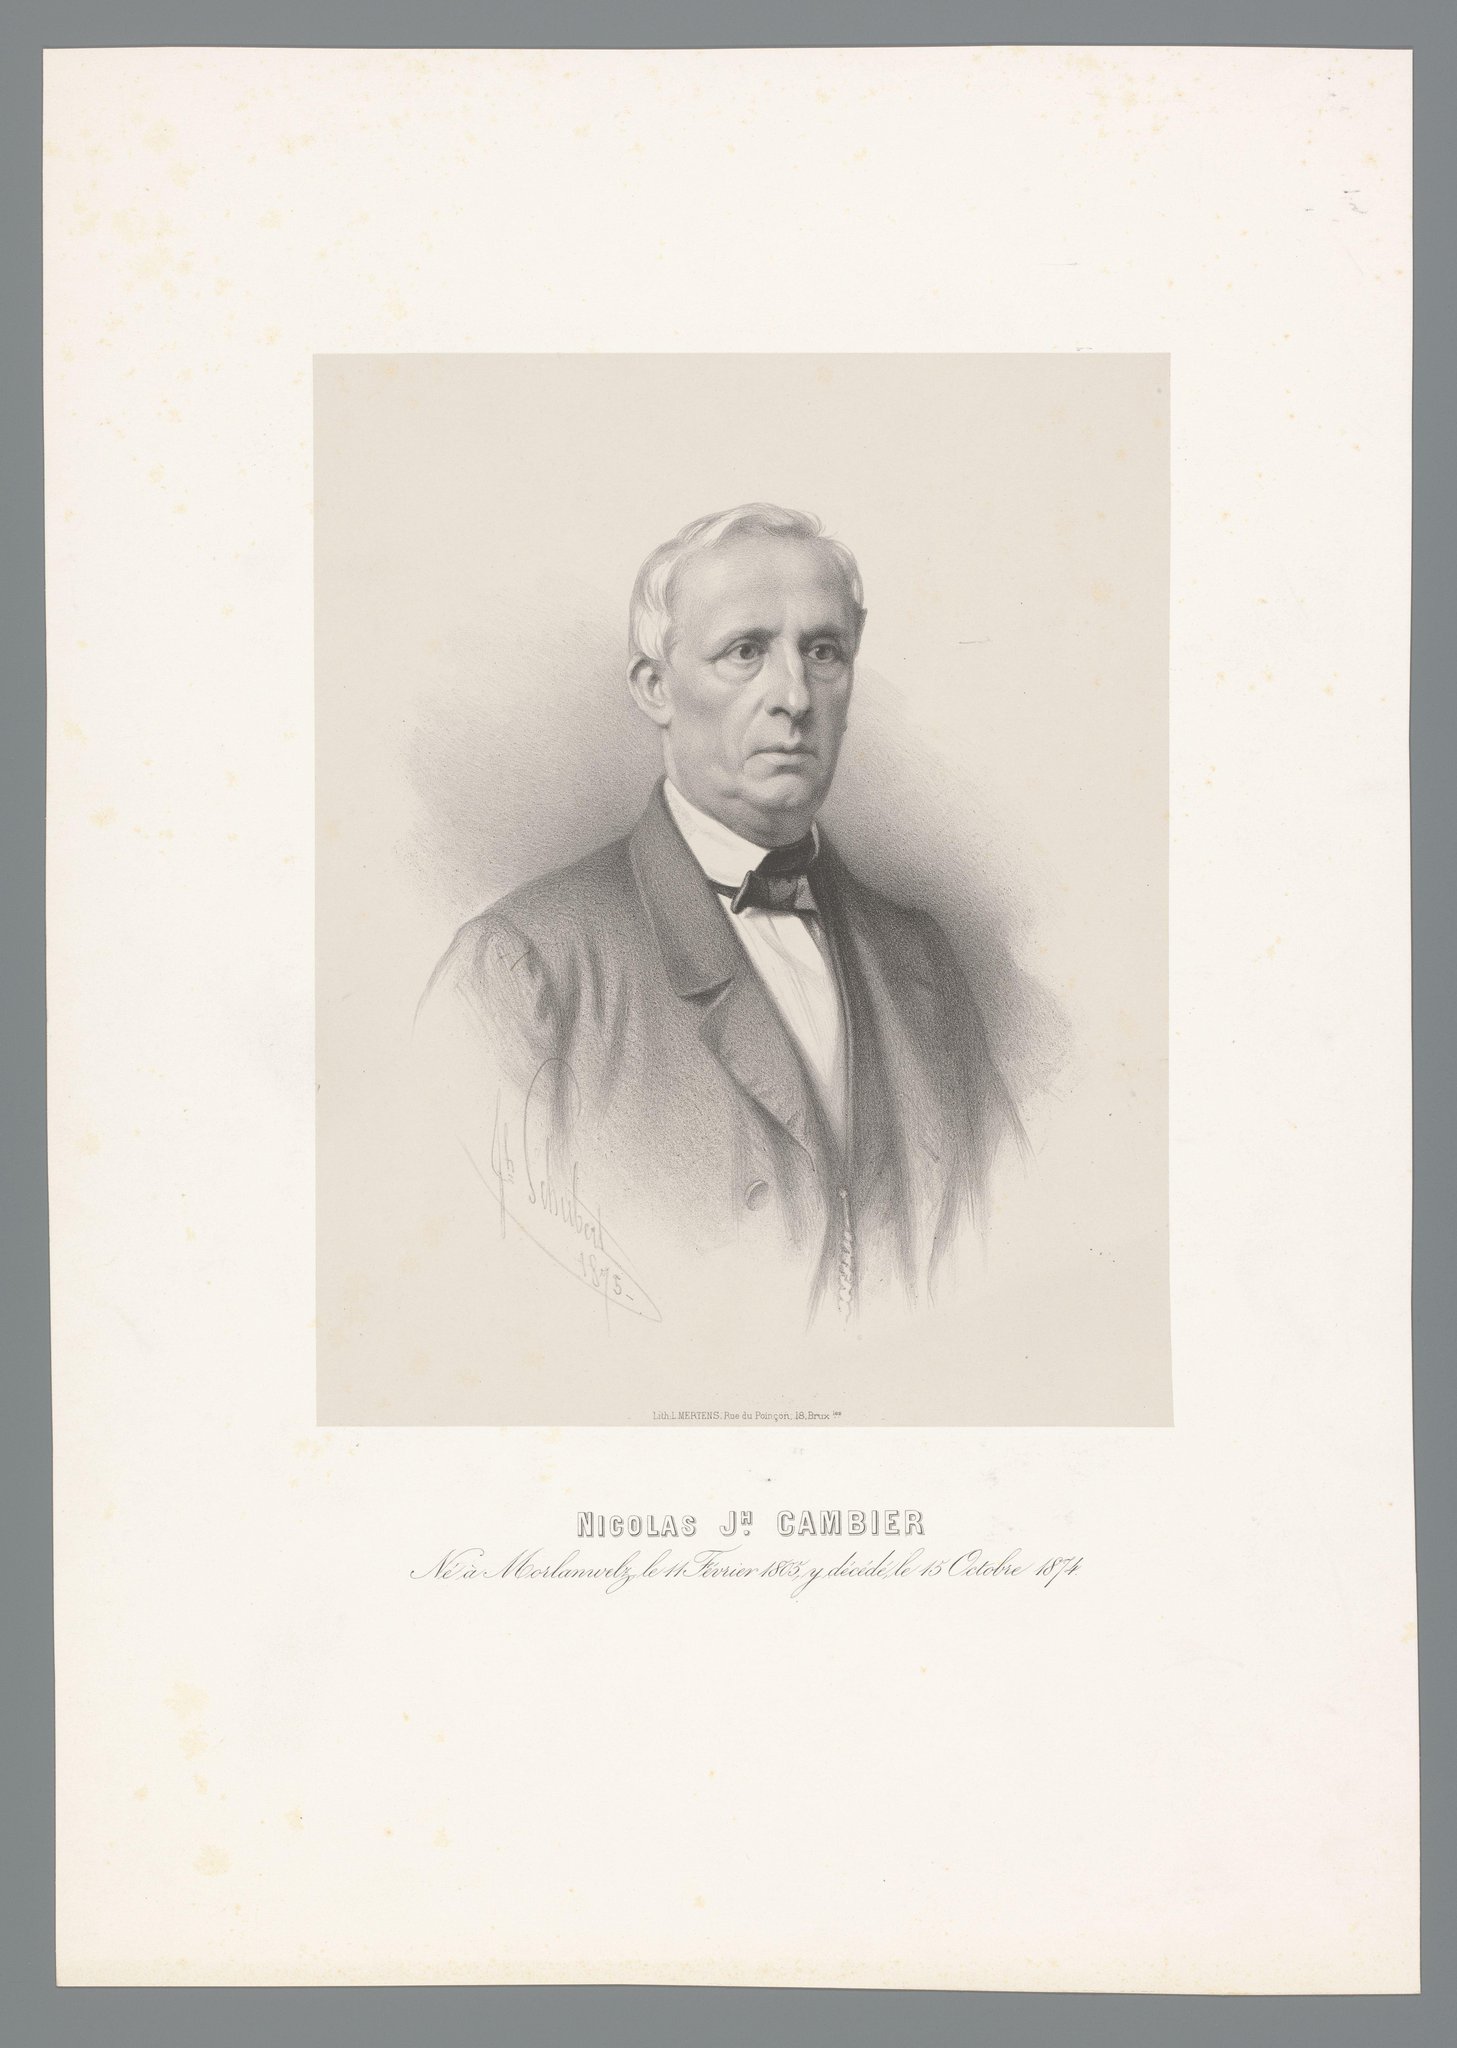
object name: print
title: Nicolas Jh. Cambier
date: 1875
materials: paper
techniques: lithograph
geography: brussels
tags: historical persons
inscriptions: collector's mark: Lugt 2228